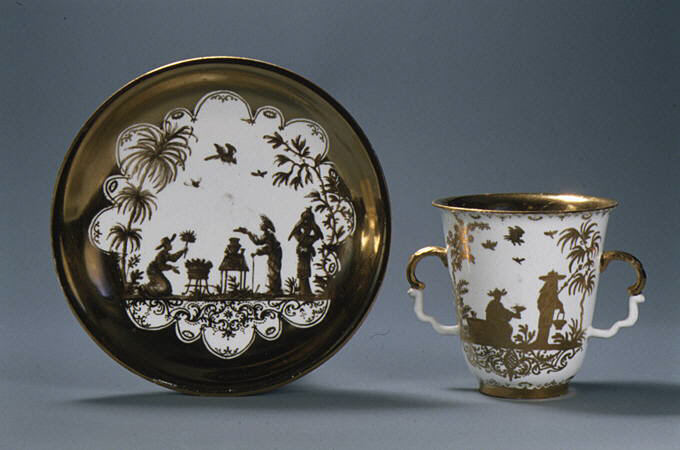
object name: beaker and saucer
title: Two-handled beaker and saucer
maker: meissen manufactory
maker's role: manufactory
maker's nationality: german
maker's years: 1710-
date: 1720-1725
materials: hard paste porcelain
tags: chinoiserie,men